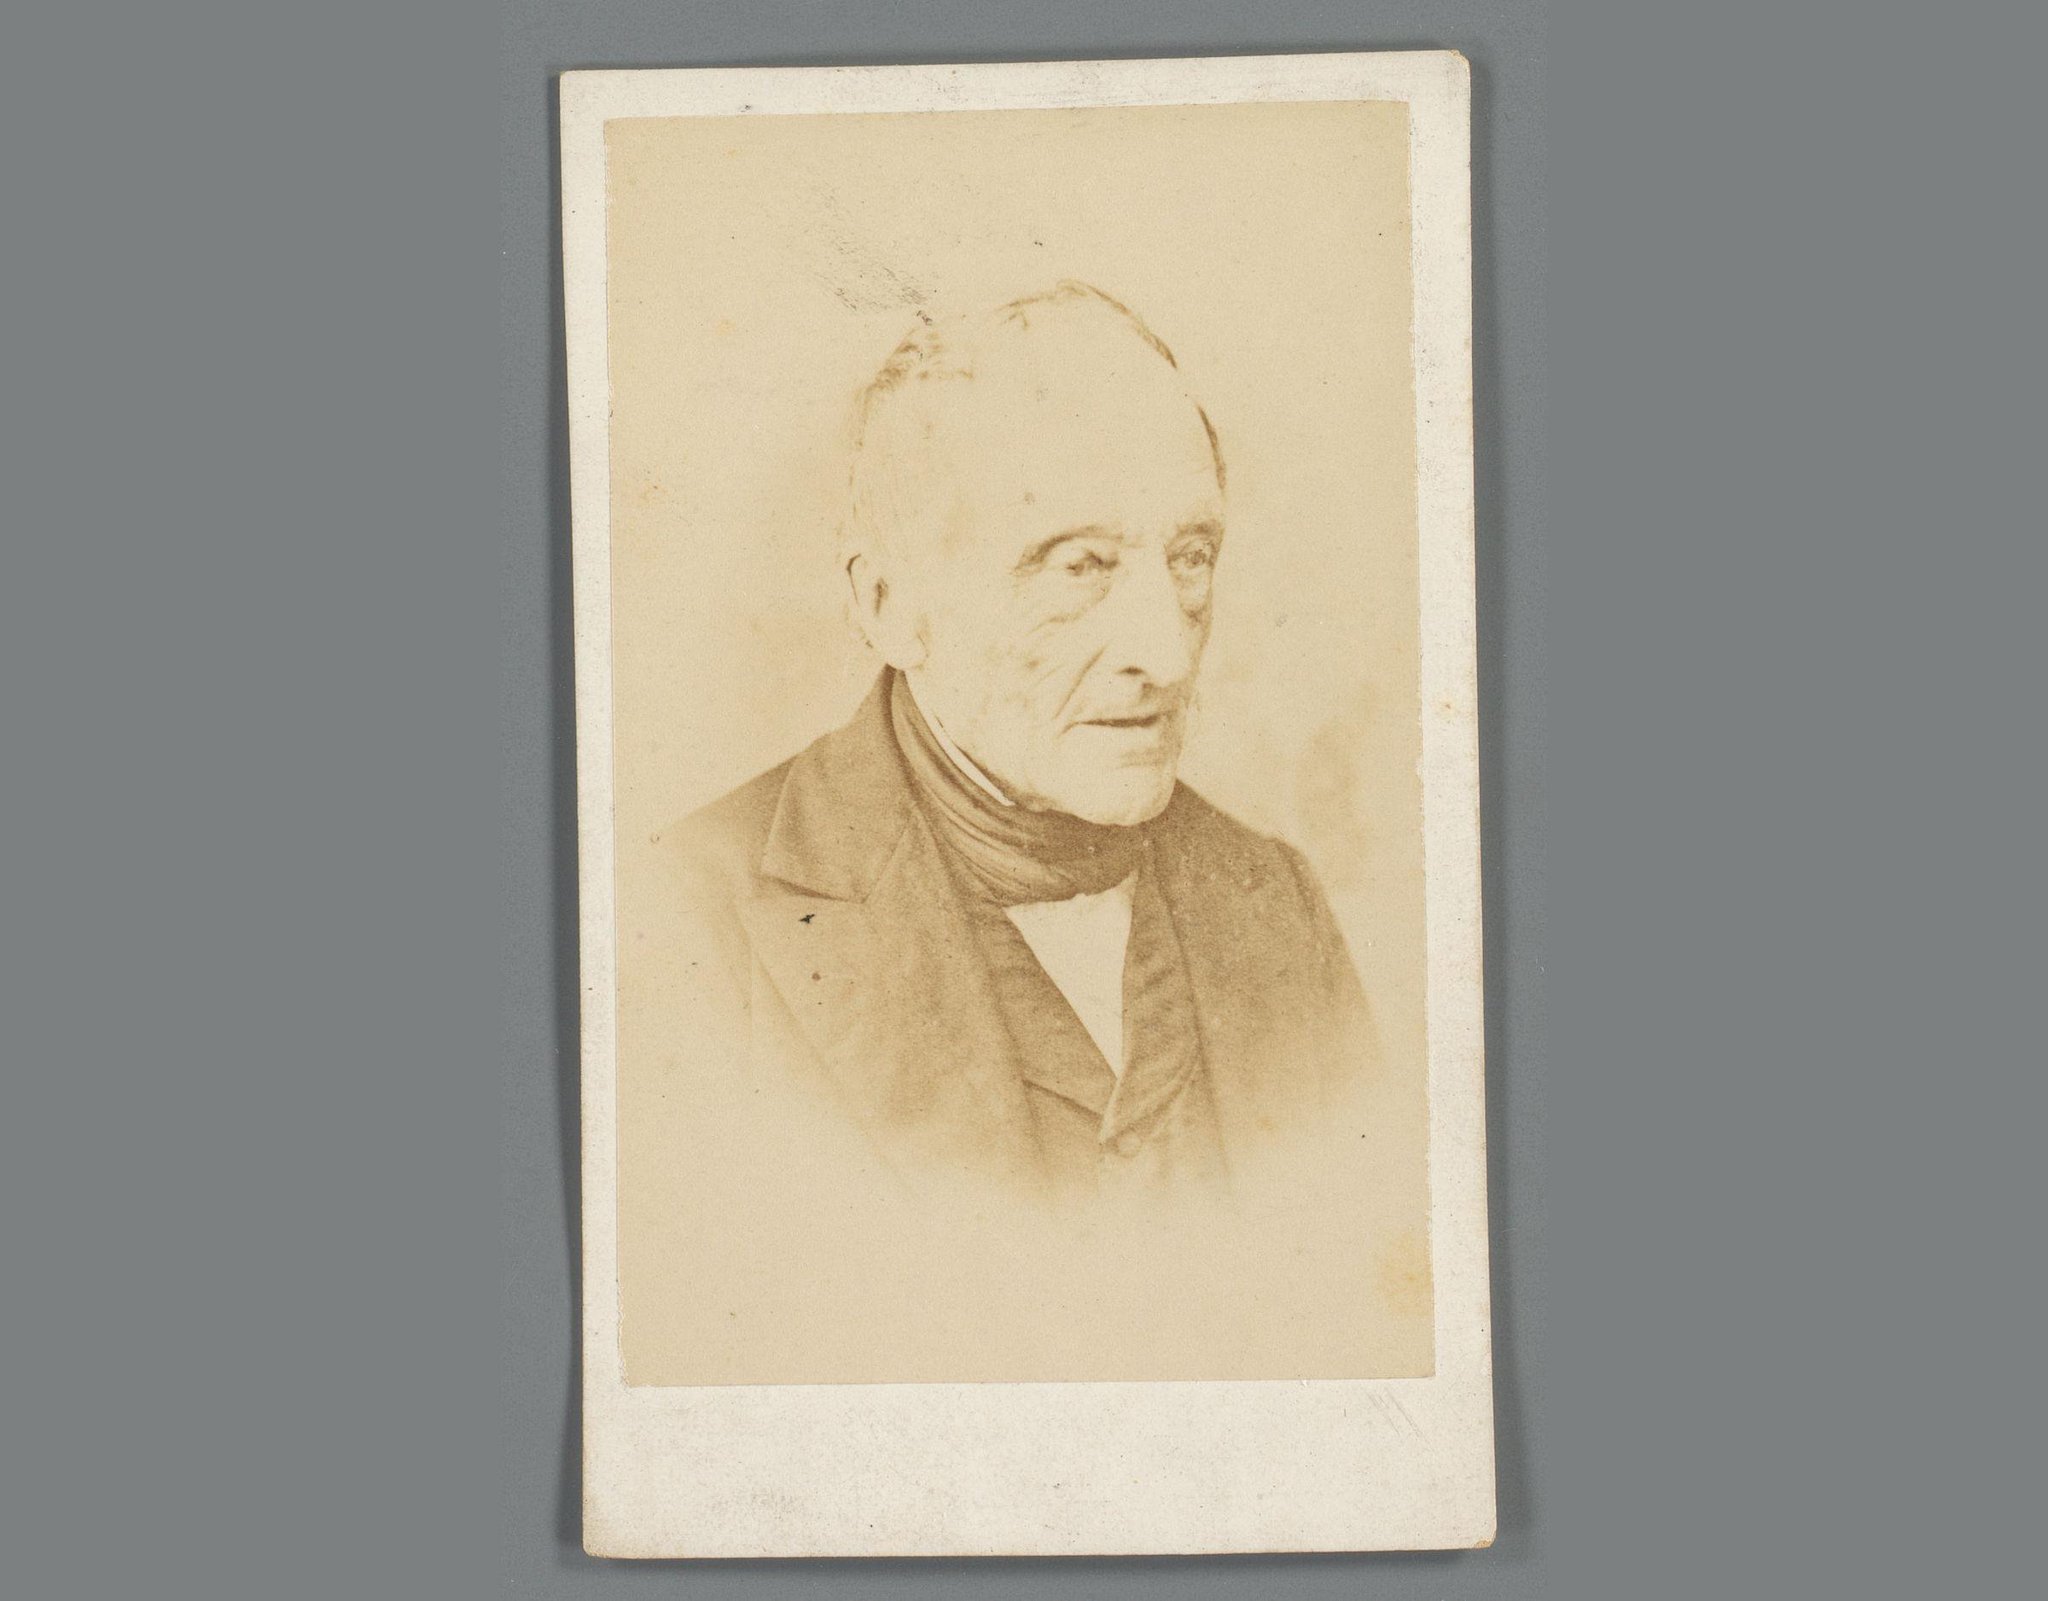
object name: photograph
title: Portret van Jan Sluijs op bidprent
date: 1877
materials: paper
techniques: albumen print, lithograph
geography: steenbergen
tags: historical persons, old man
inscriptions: inscription: ‘Jan Sluijs/ Poldervoogd/ van/ Cruijslands Polders, enz./ Geboren te Texel 22 Augustus 1797./ Overleden te Steenbergen, 25 November 1877./ Hij ruste in vrede/ Amsterdam B. Lenfring Rotterdam’